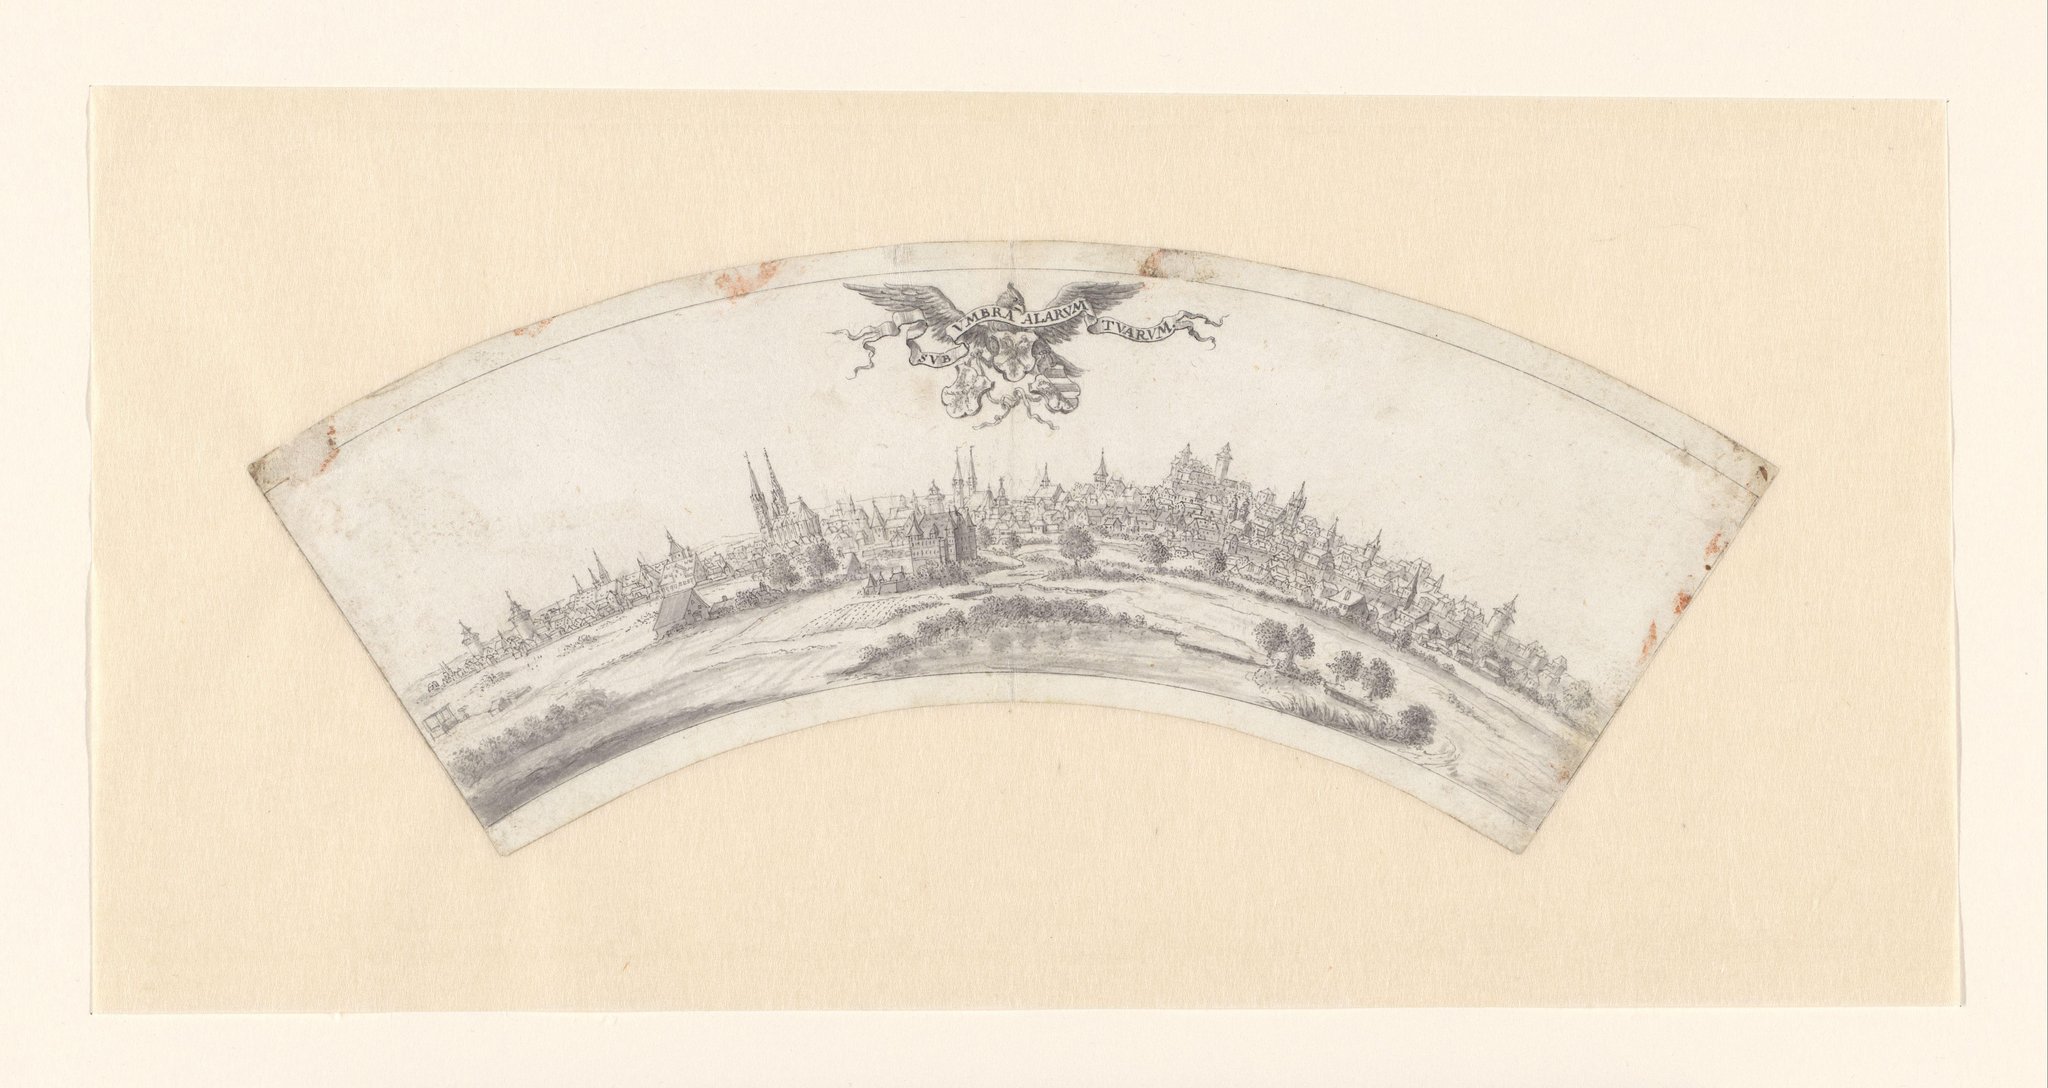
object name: design drawing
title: Gezicht op de stad Neurenberg, ontwerp voor de radgravure op een drinkglas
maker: Anonymous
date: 1680-1700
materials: graphite, ink, paper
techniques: brush, pen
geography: nuremberg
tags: neurenberg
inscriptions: inscription: ‘SVB VMBRA ALARVM TVARVM’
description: Boven de voorstelling vliegt een adelaar met uitgespreide vleugels, met een banderol met het opschrift SVB VMBRA ALARVM TVARVM [onder de bescherming van Uw vleugels] en de met linten verbonden wapens van de stad Neurenberg.